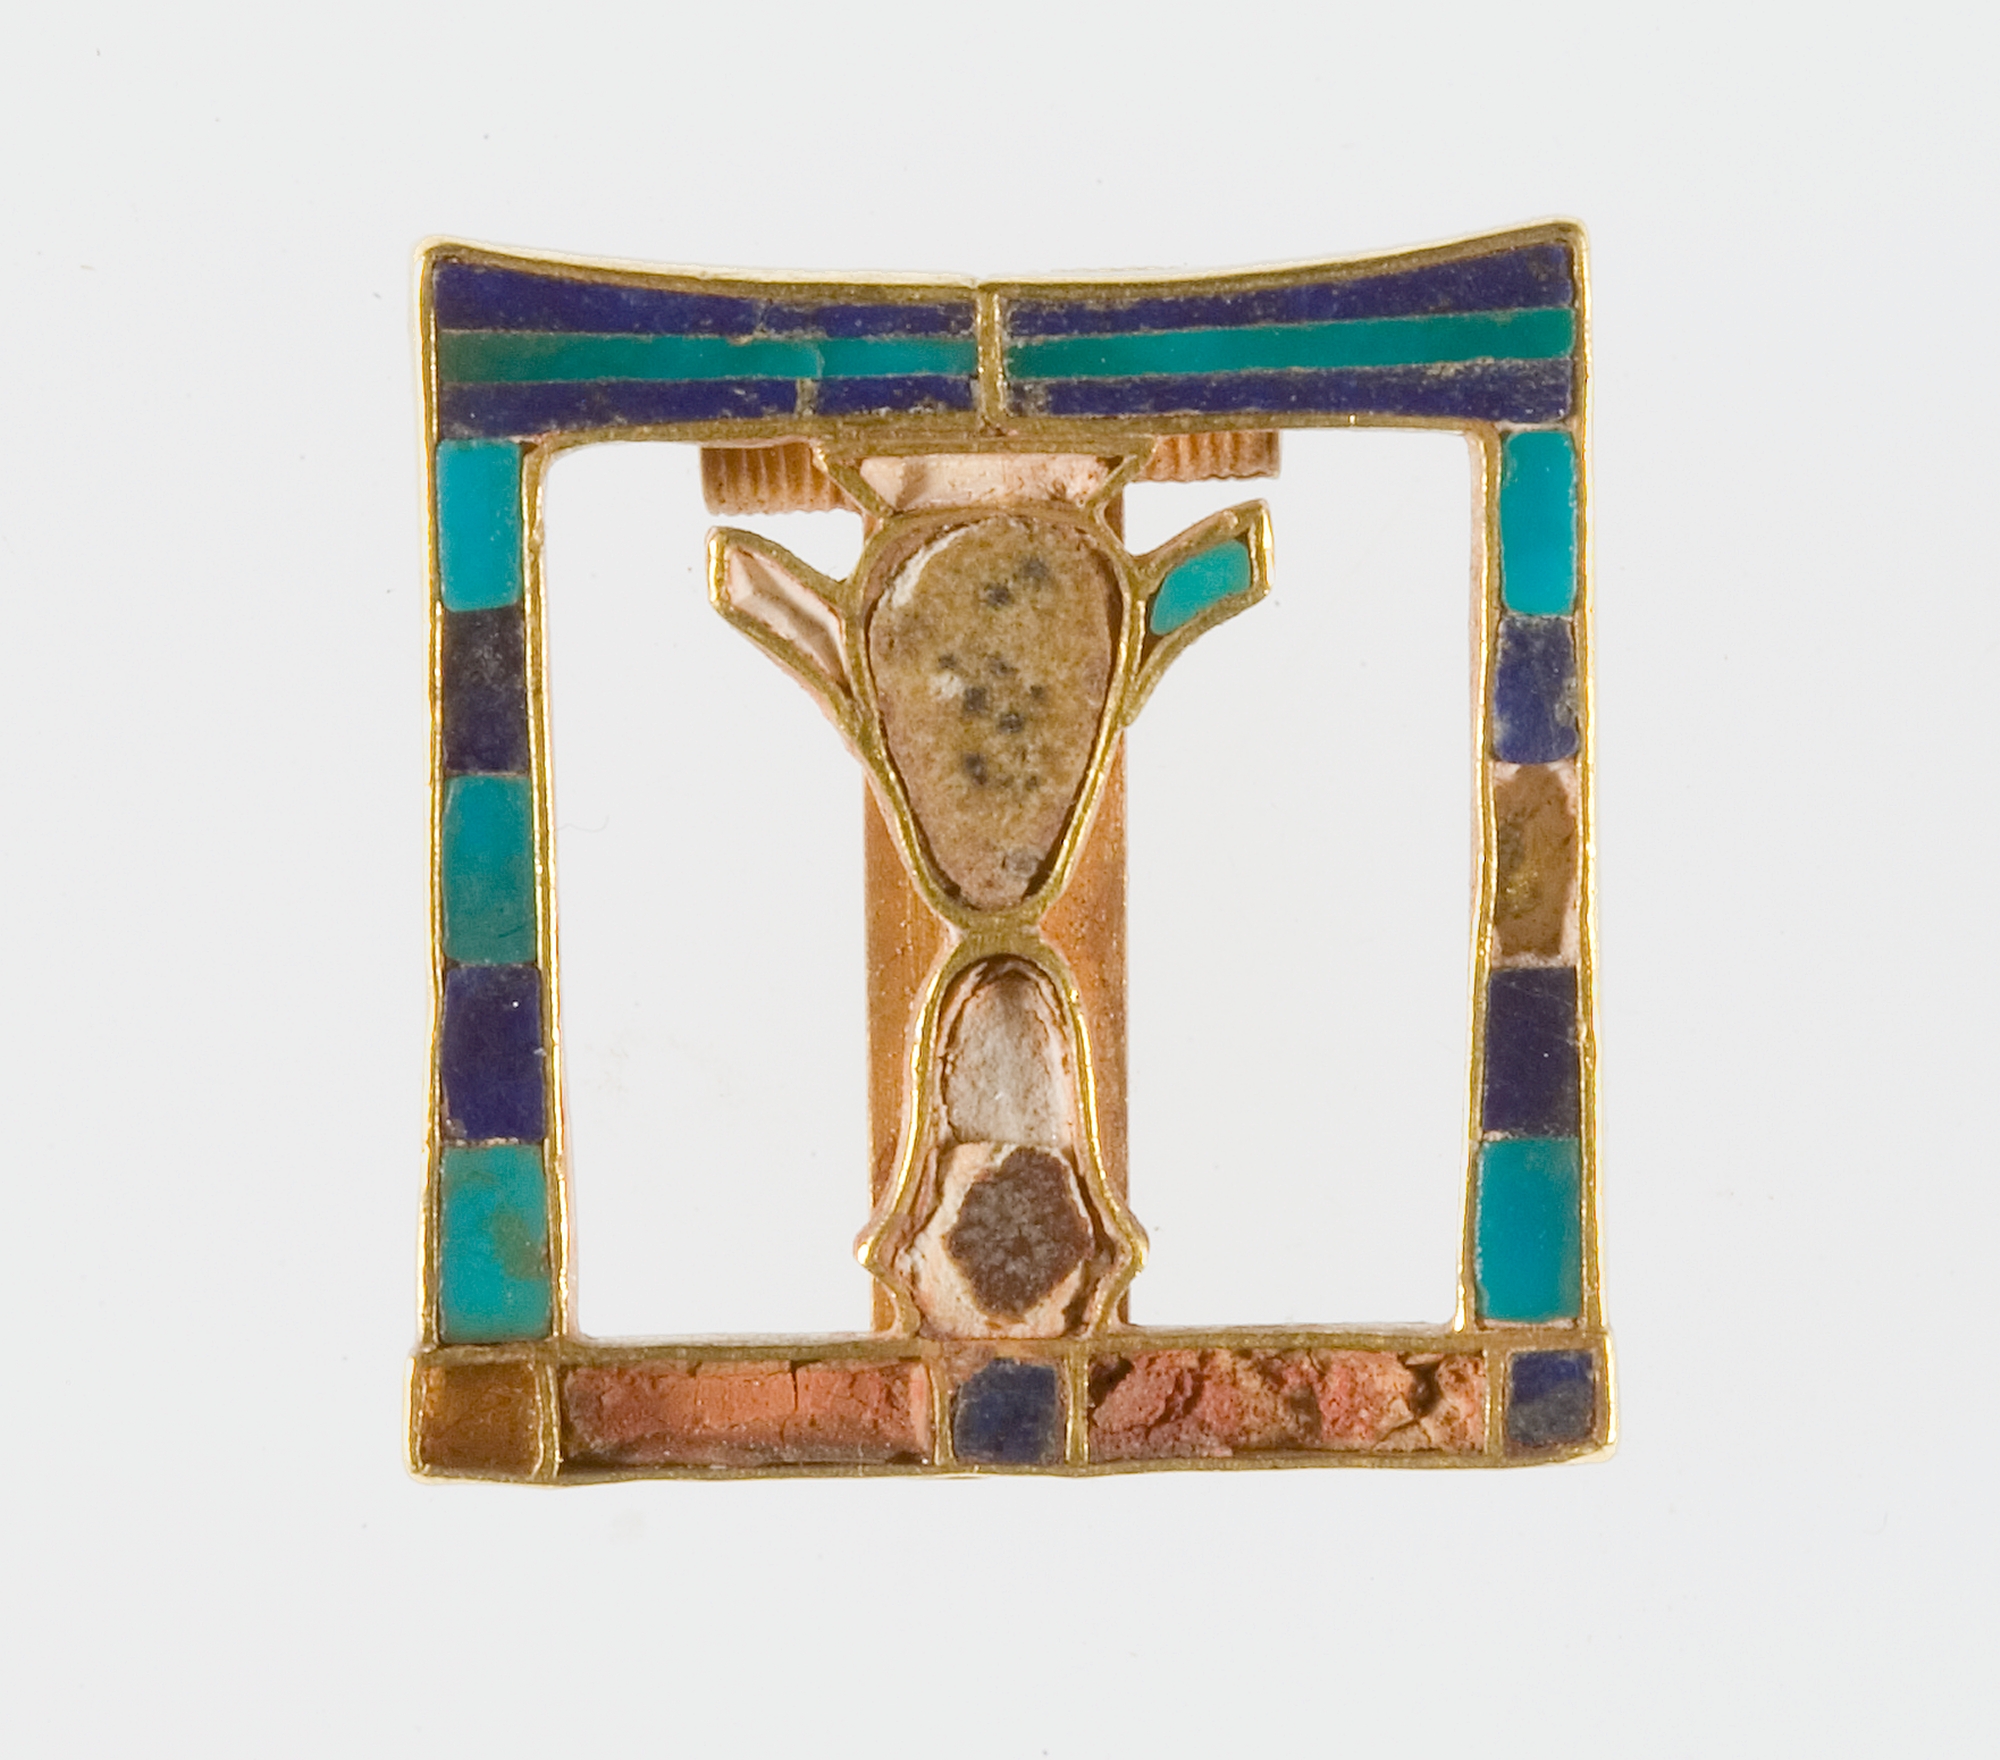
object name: clasp, heart sign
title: Motto Clasp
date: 1878-1805 BCE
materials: gold, stone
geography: memphite region